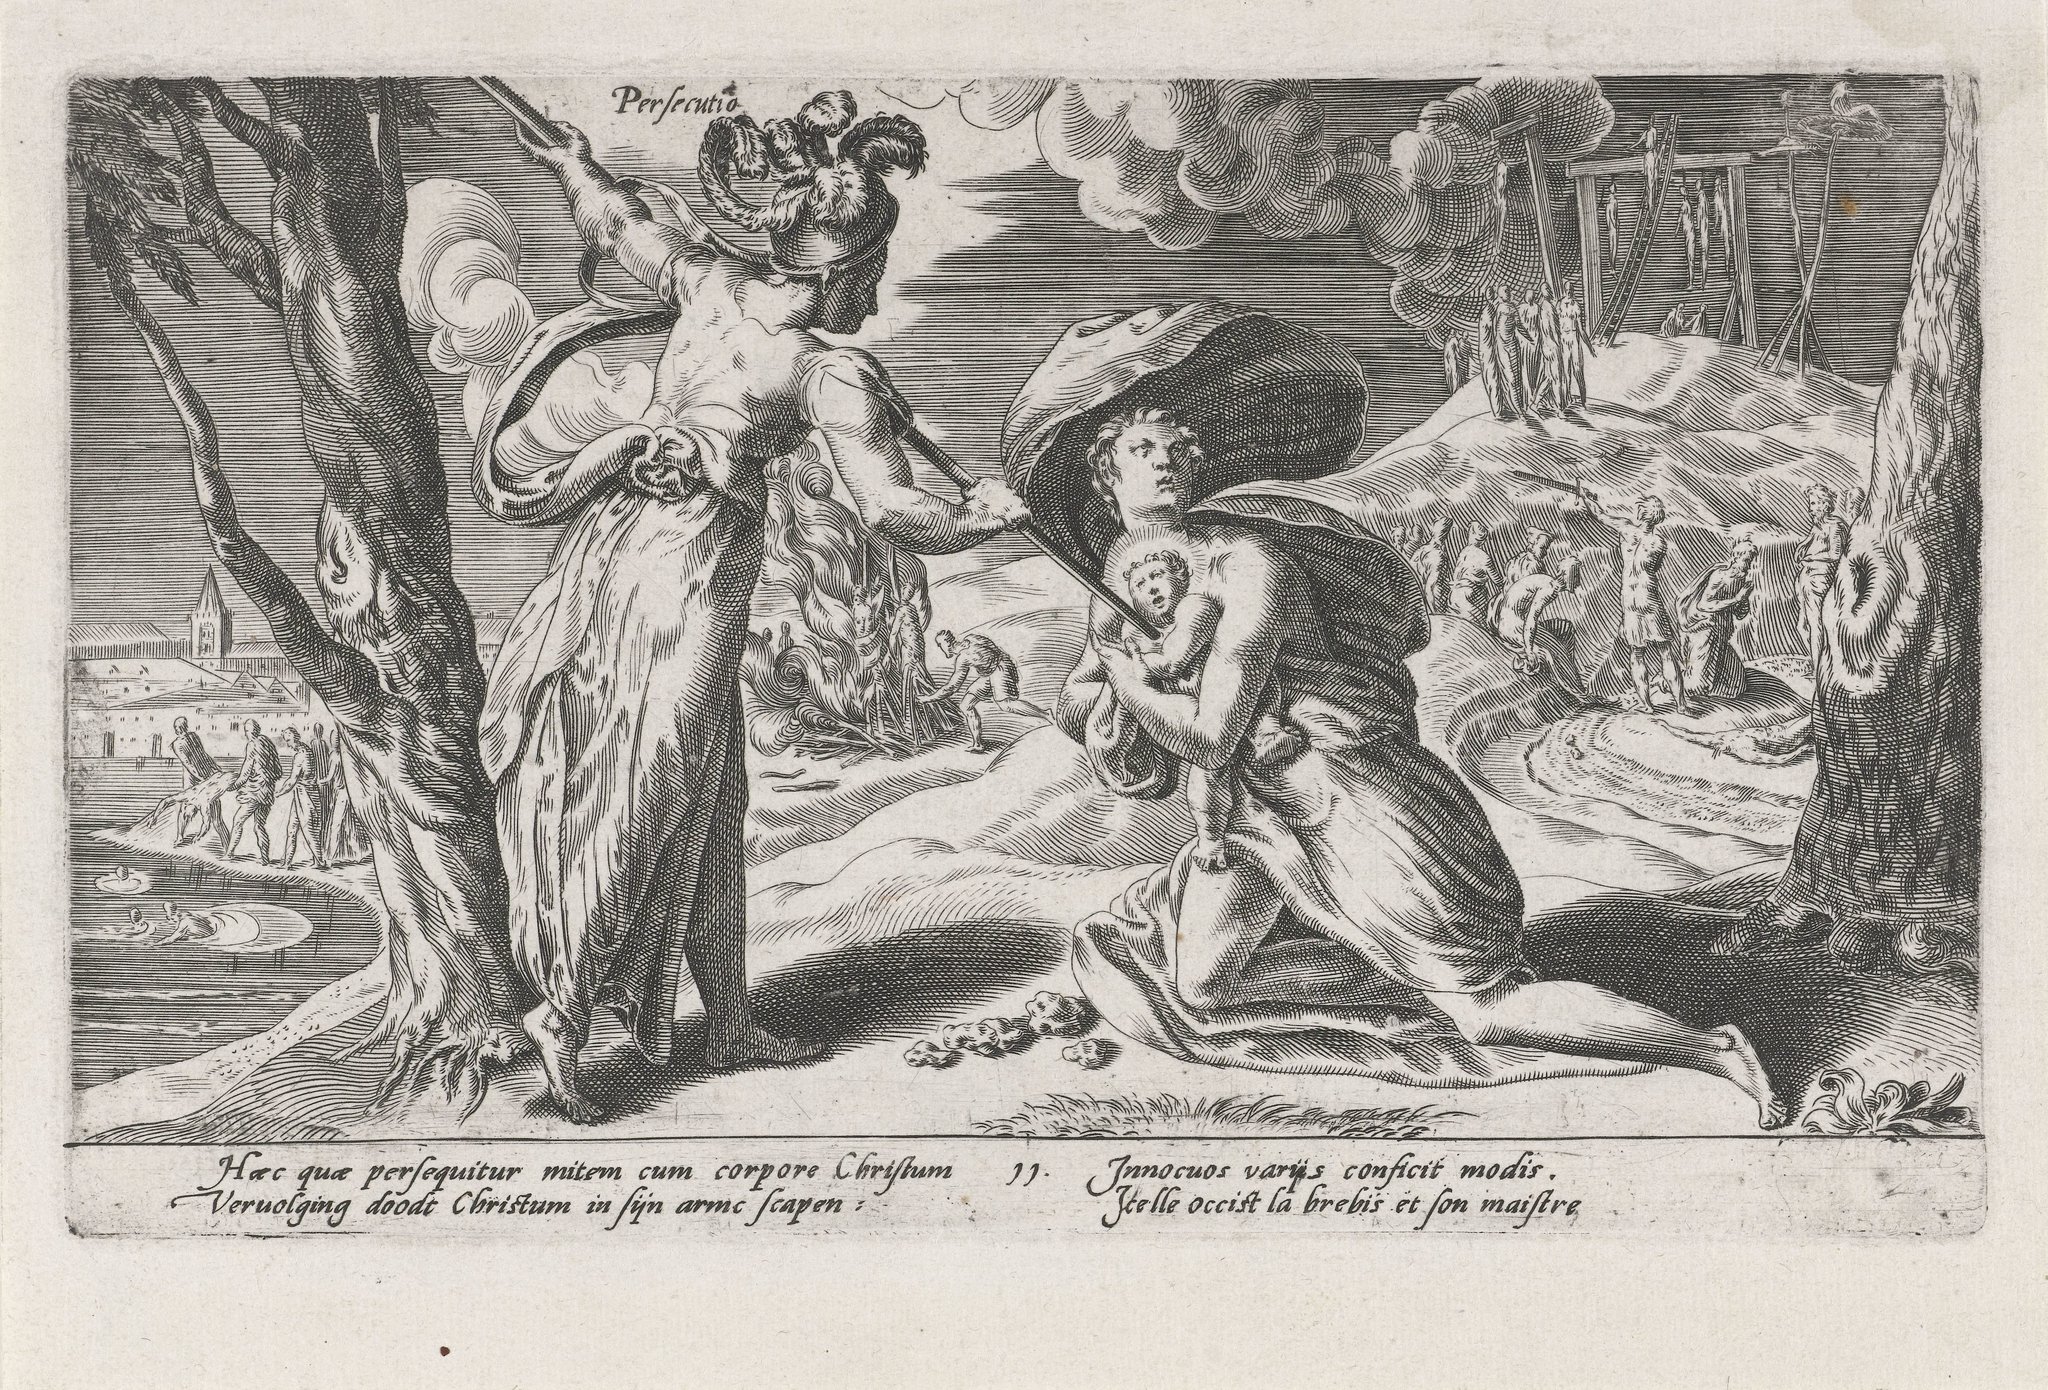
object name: print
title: Onschuldige Christenen worden vervolgd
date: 1604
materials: paper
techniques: engraving, etching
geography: germany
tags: violent death by hanging, death penalty, execution, violent death by burning at the stake; pyre, drowning (violent death ~ water), 'fuga', 'fuga popolare', 'persecutione' (ripa), low countries, beeldenstorm (1566)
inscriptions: collector's mark: Lugt 2228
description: De personificatie Vervolging (Persecutio) brengt met een speer twee onschuldige christenen, een moeder en kind, om het leven. In de achtergrond worden burgers gedood door verdrinking, verbranding, onthoofding of ophanging. De prent heeft een Nederlands, Latijns en Frans onderschrift en maakt deel uit van een twaalfdelige serie met als onderwerp de ontaarding van de katholieke geestelijkheid en de oorzaken van de opstand en de Beeldenstorm.